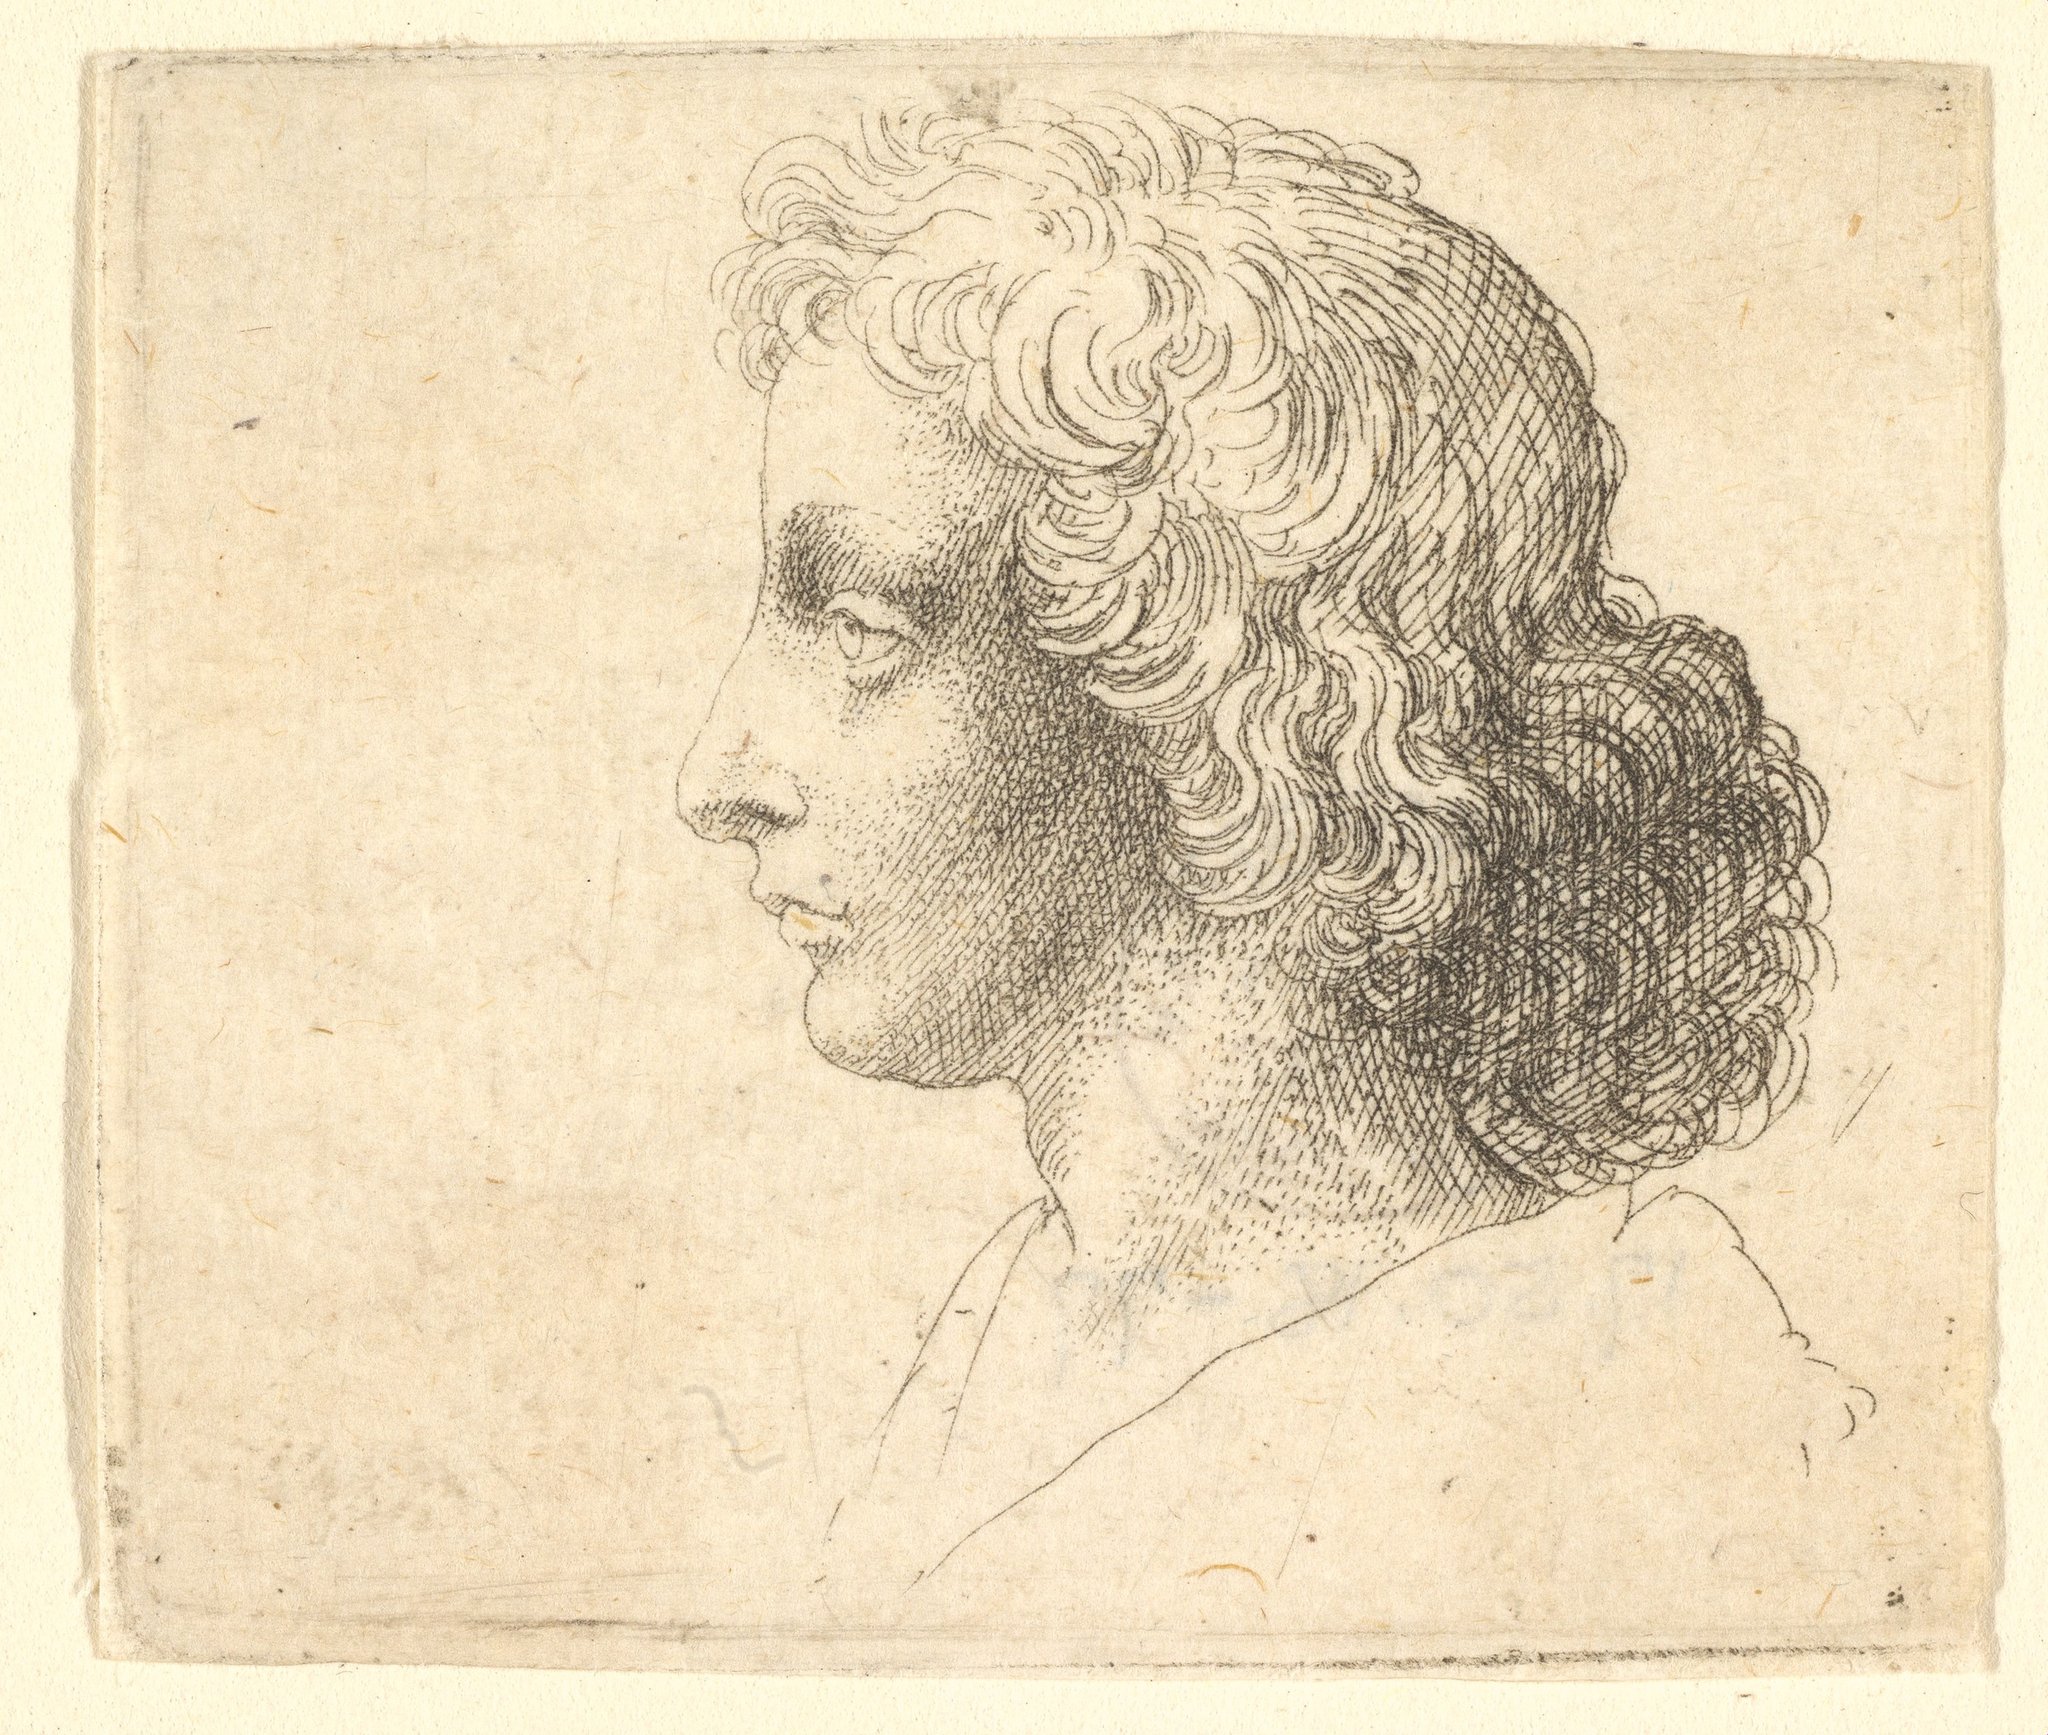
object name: print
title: Head of young man with long hair in profile to the left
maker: wenceslaus hollar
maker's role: artist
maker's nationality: bohemian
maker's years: 1607-1677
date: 1644-1652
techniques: etching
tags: men